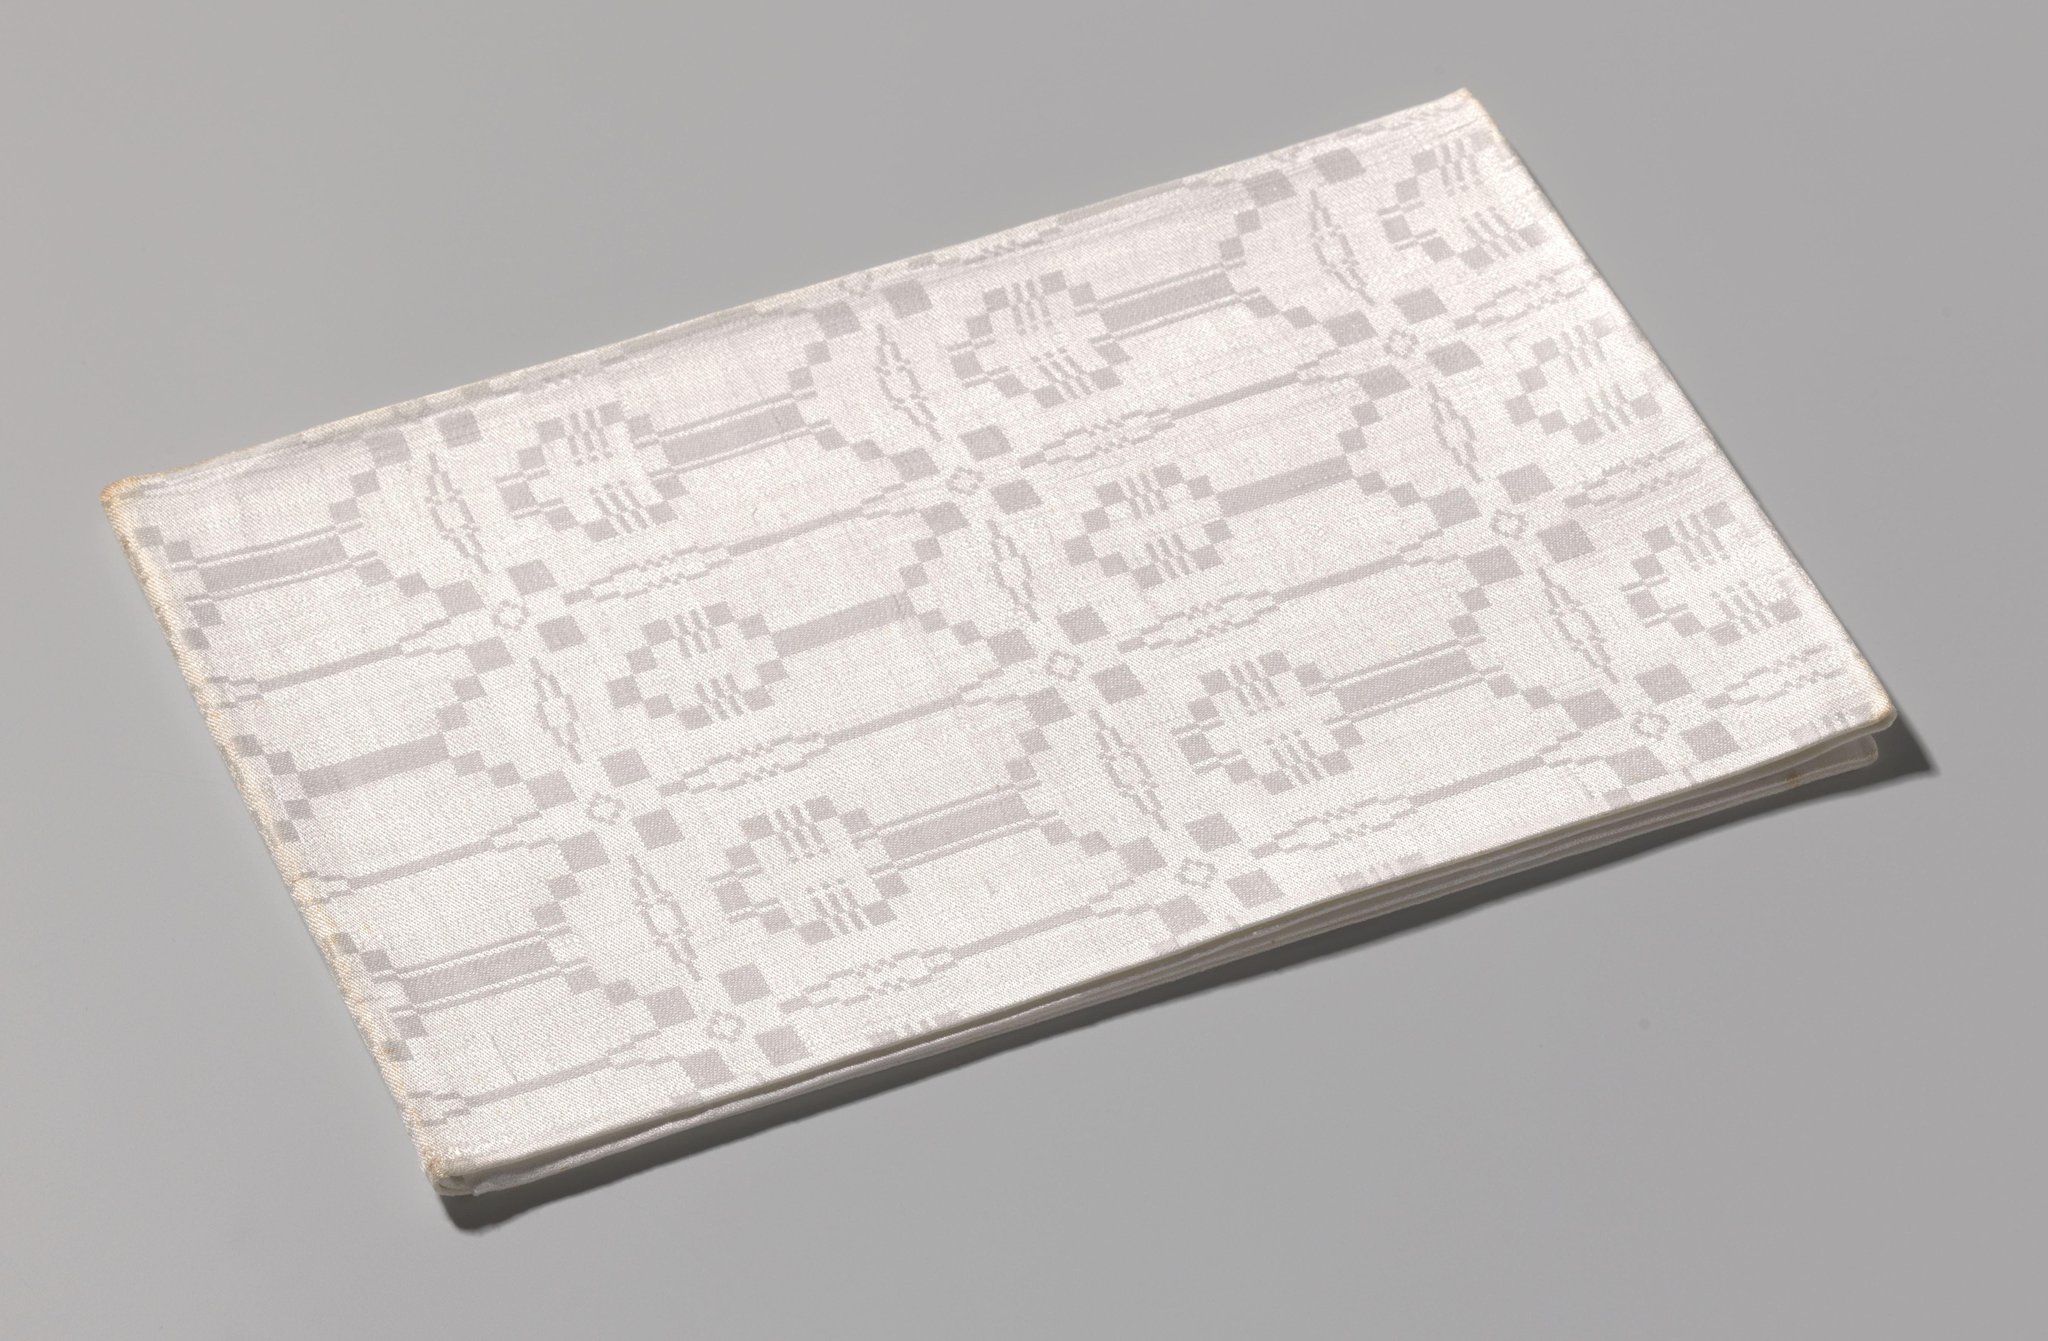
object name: napkin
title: Servet van linnen met pellenpatroon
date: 1726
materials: linen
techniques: peeled fabric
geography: northern netherlands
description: wit linnen servet met pellen patroon, merk GS 60 en 1726